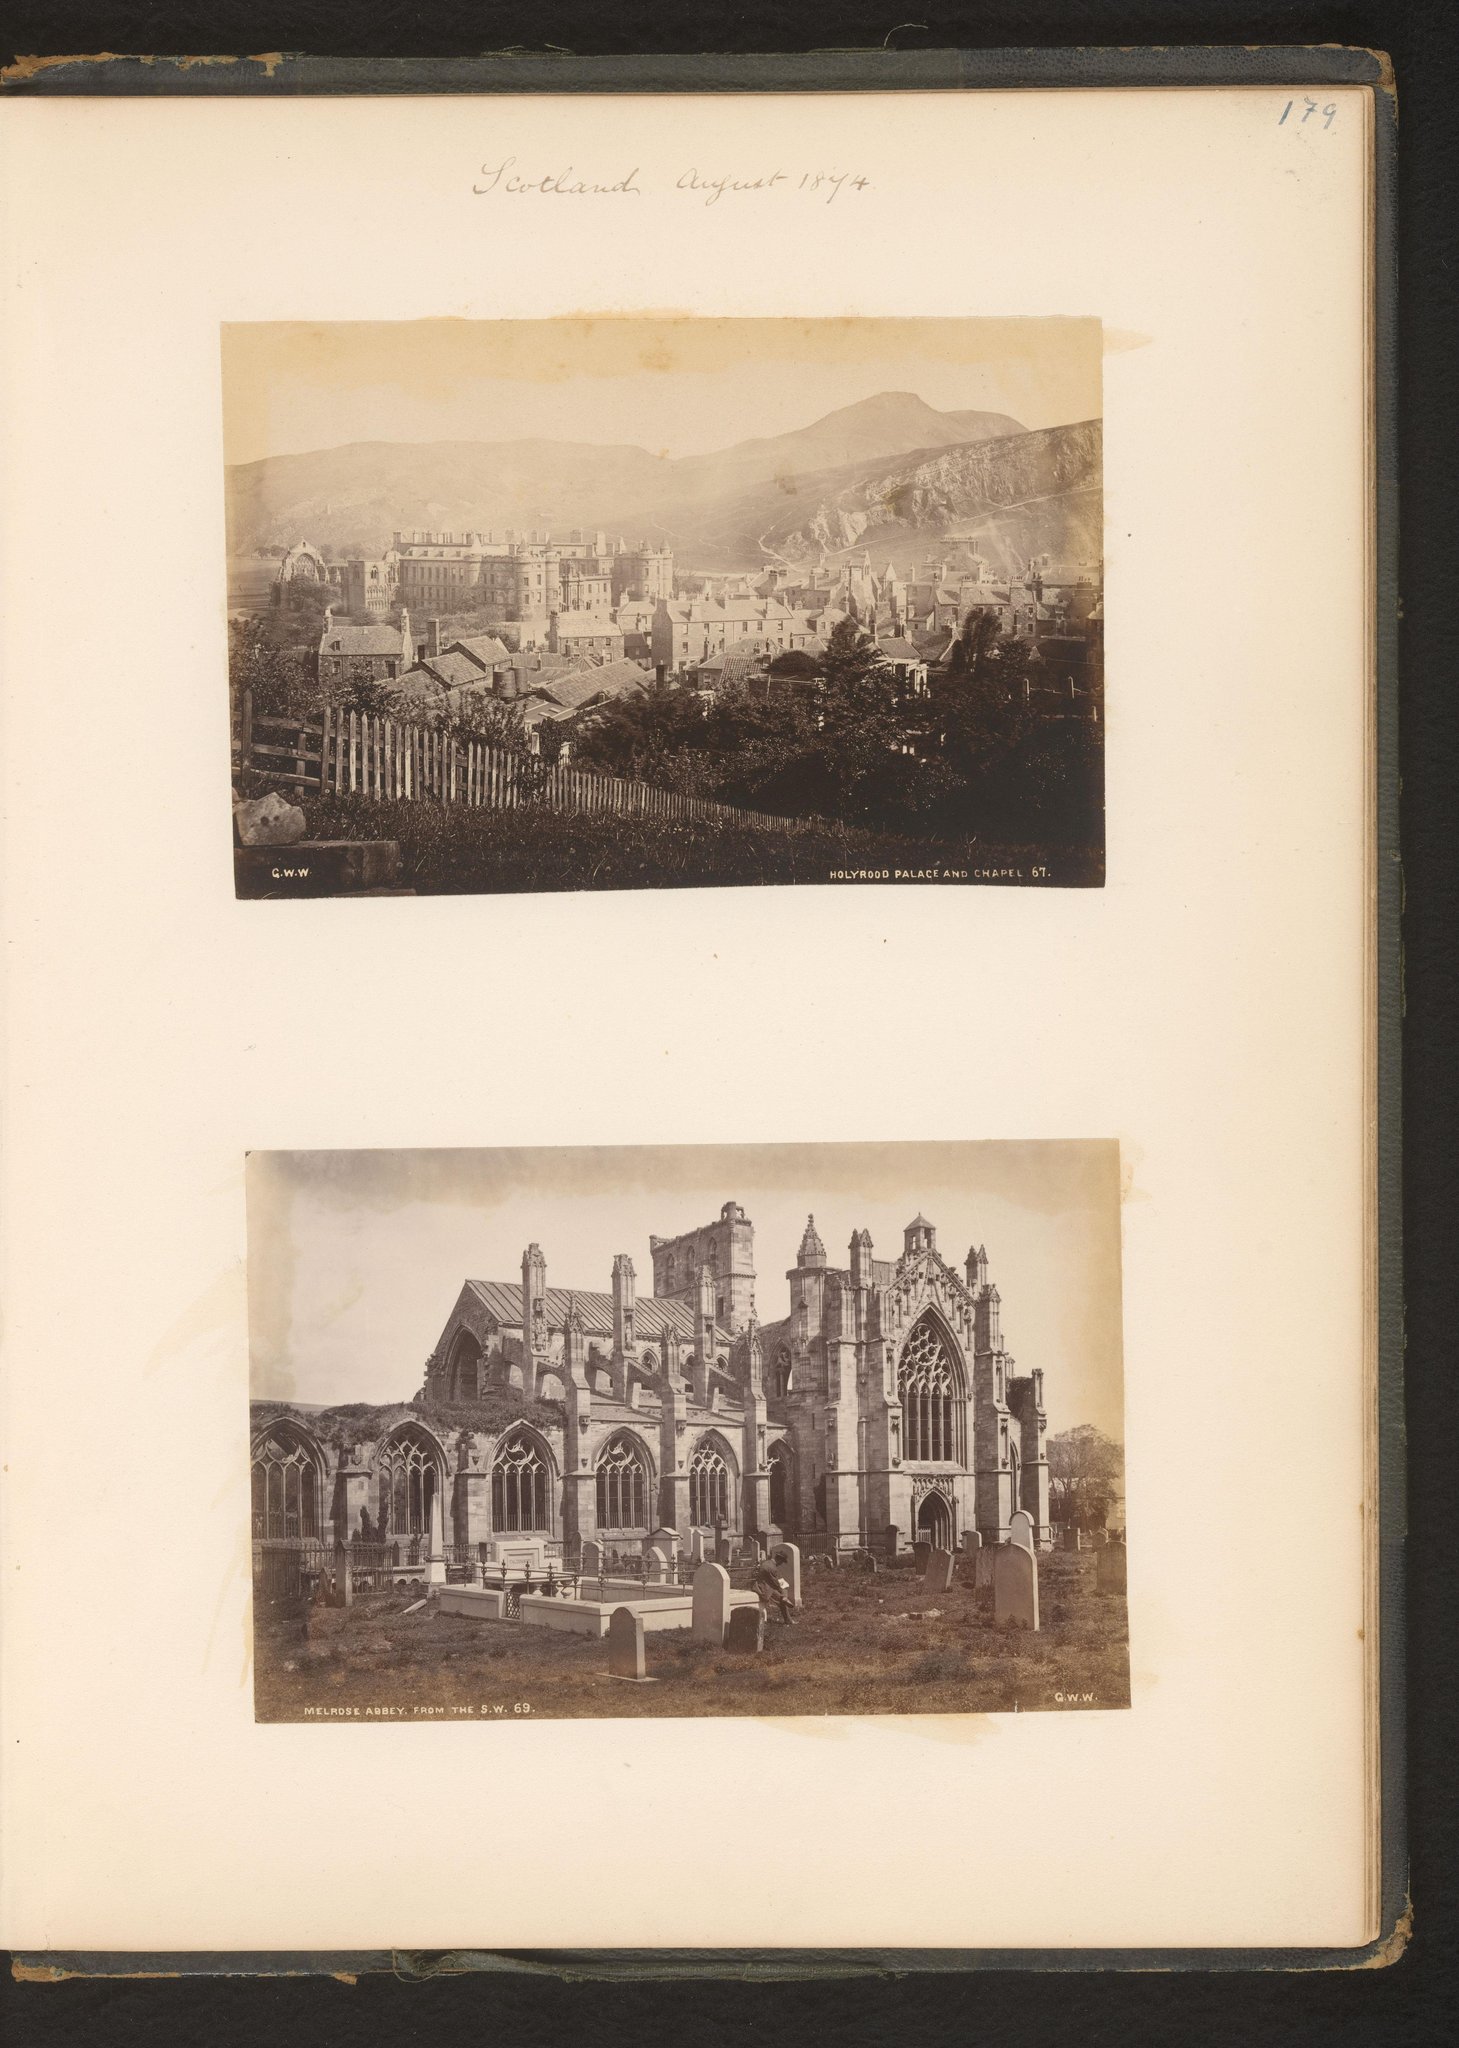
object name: album leaf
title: Holyrood Palace te Edinburgh en Melrose Abbey te Melrose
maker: Anonymous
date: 1808-1874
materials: paper, photographic support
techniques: albumen print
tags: ruin of a building ~ architecture, palace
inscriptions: inscription: ‘G.W.W. Holyrood Palace and Chapel. 67.’, inscription: ‘Melrose Abbey, from the S.W. 69. G.W.W.’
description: Deze pagina maakt deel uit van een album.